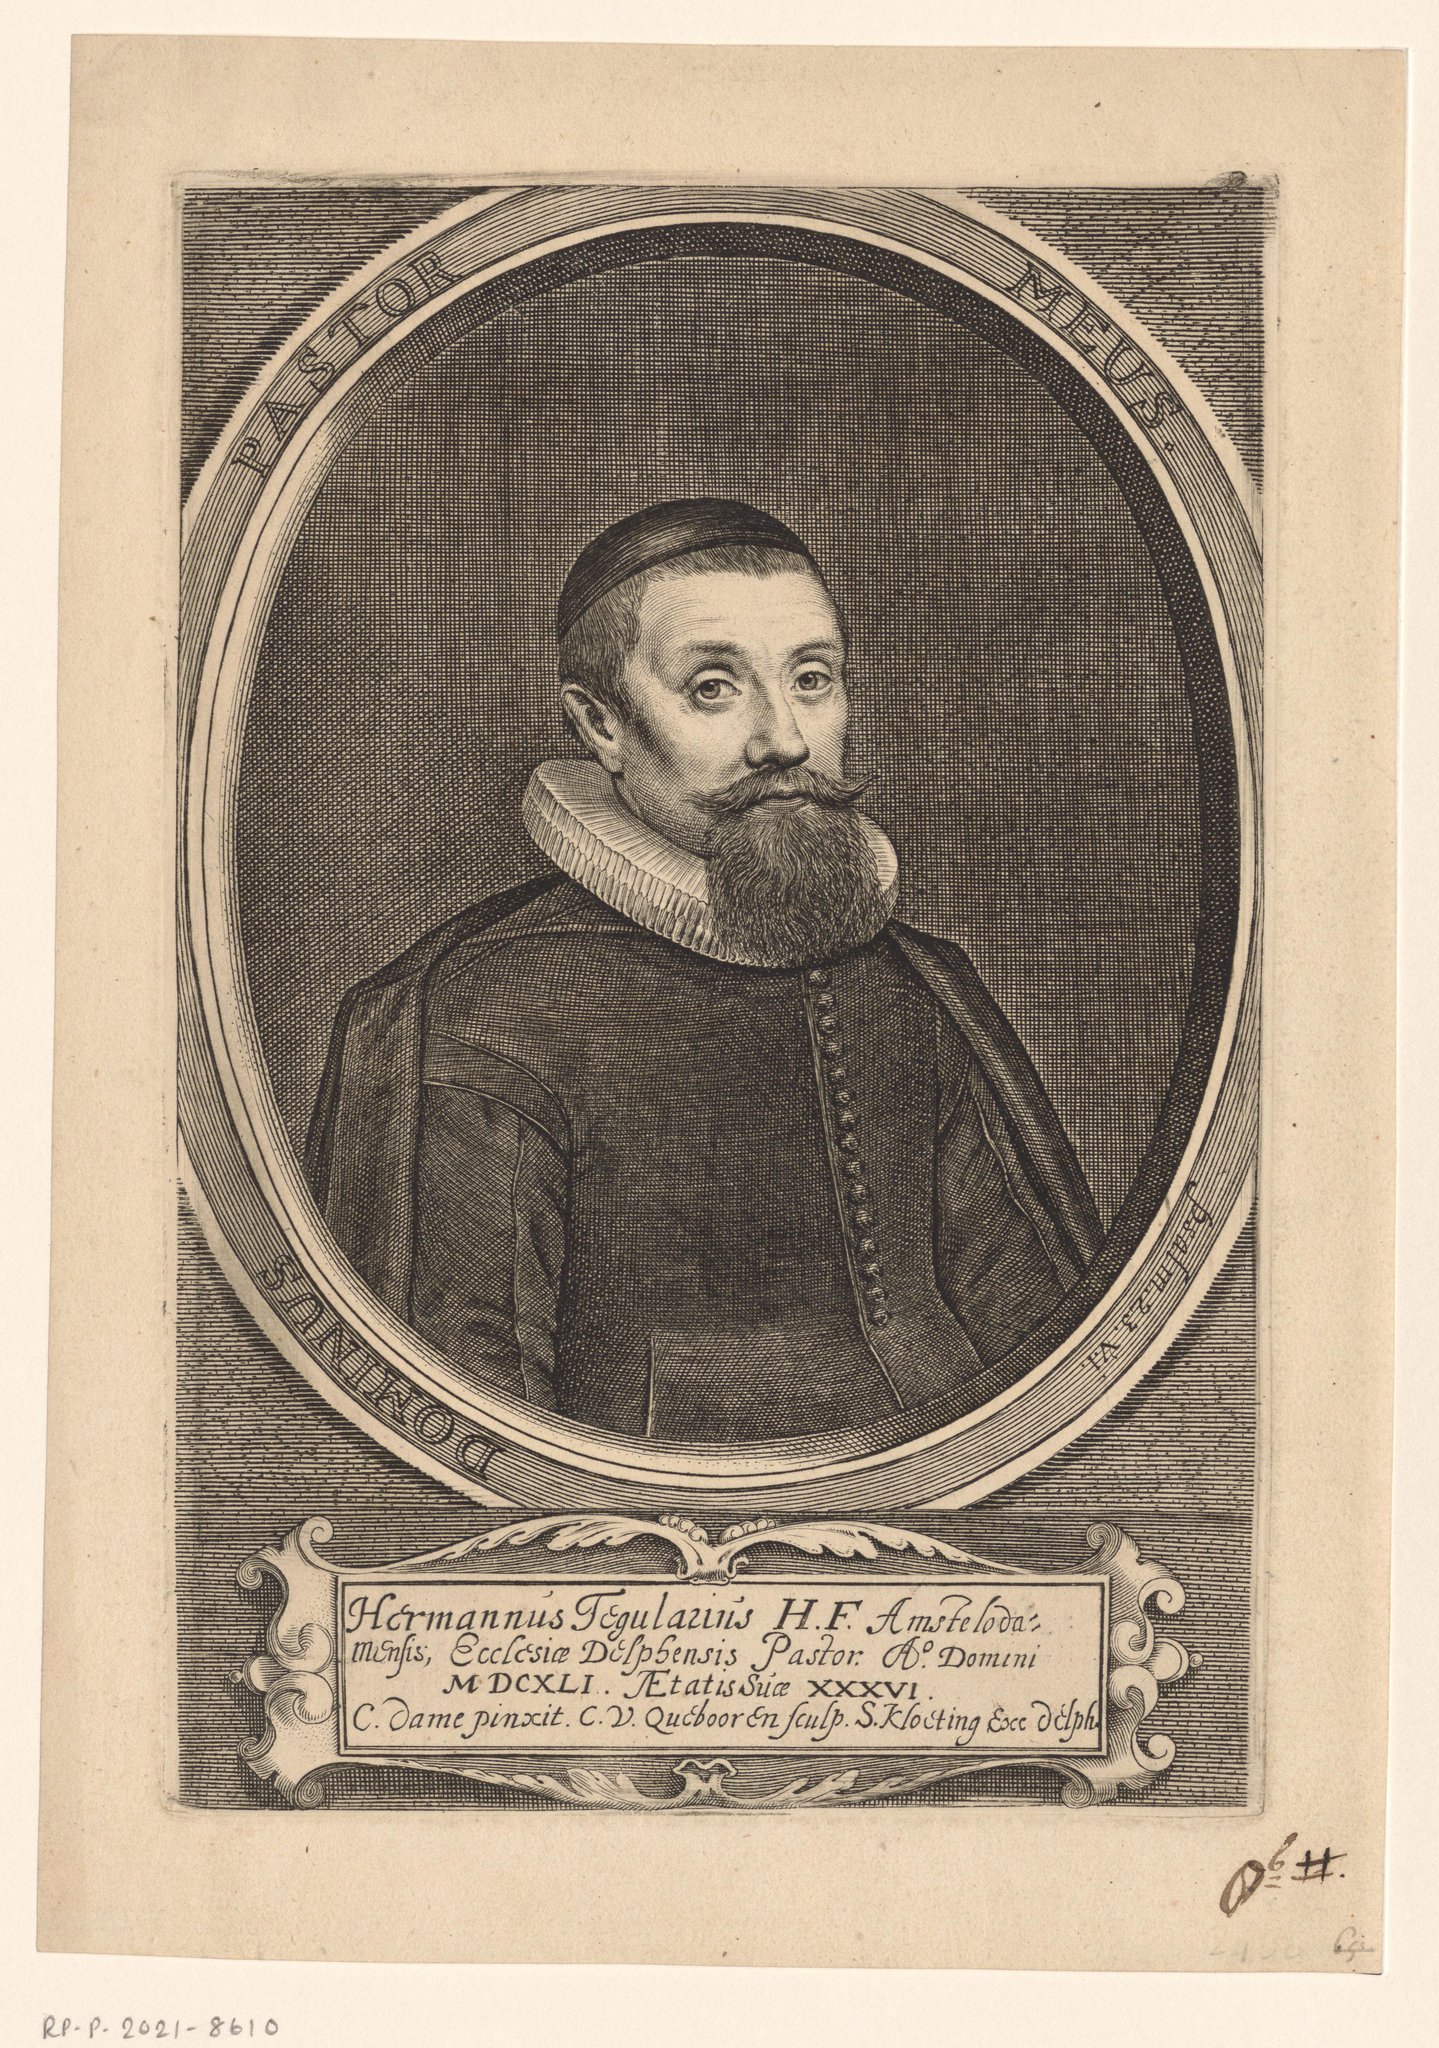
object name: print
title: Portret van Hermannus Tegularius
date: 1641-1652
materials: paper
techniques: engraving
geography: delft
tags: historical persons, functionaries and dignitaries ~ episcopal protestant churches